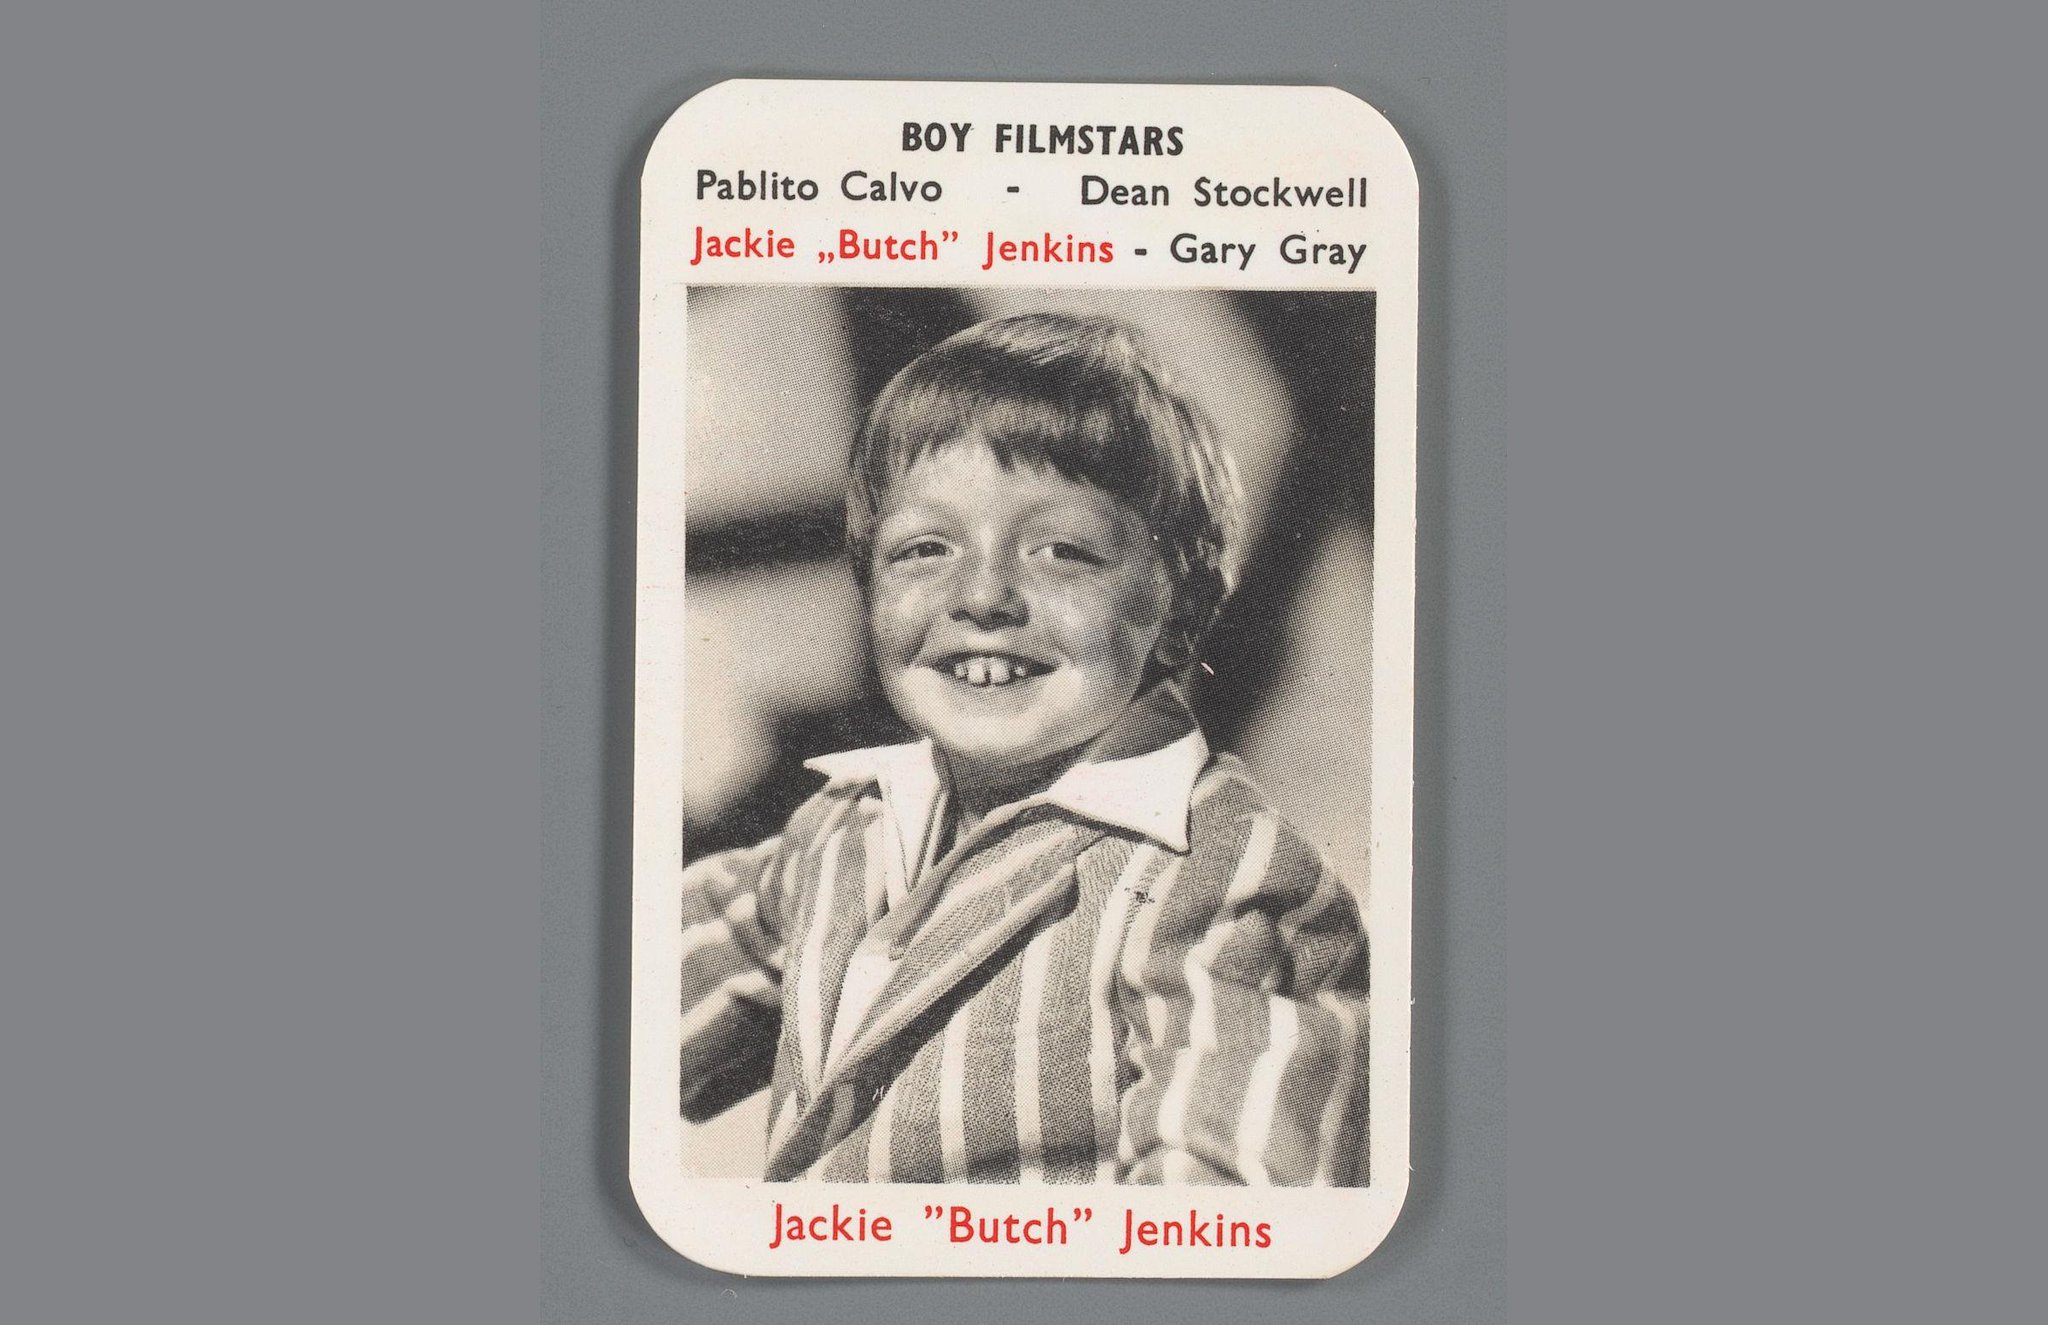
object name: playing card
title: Boy Filmstars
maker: Anonymous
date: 1960-1970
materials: paper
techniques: autotype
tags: portrait of actor, actress